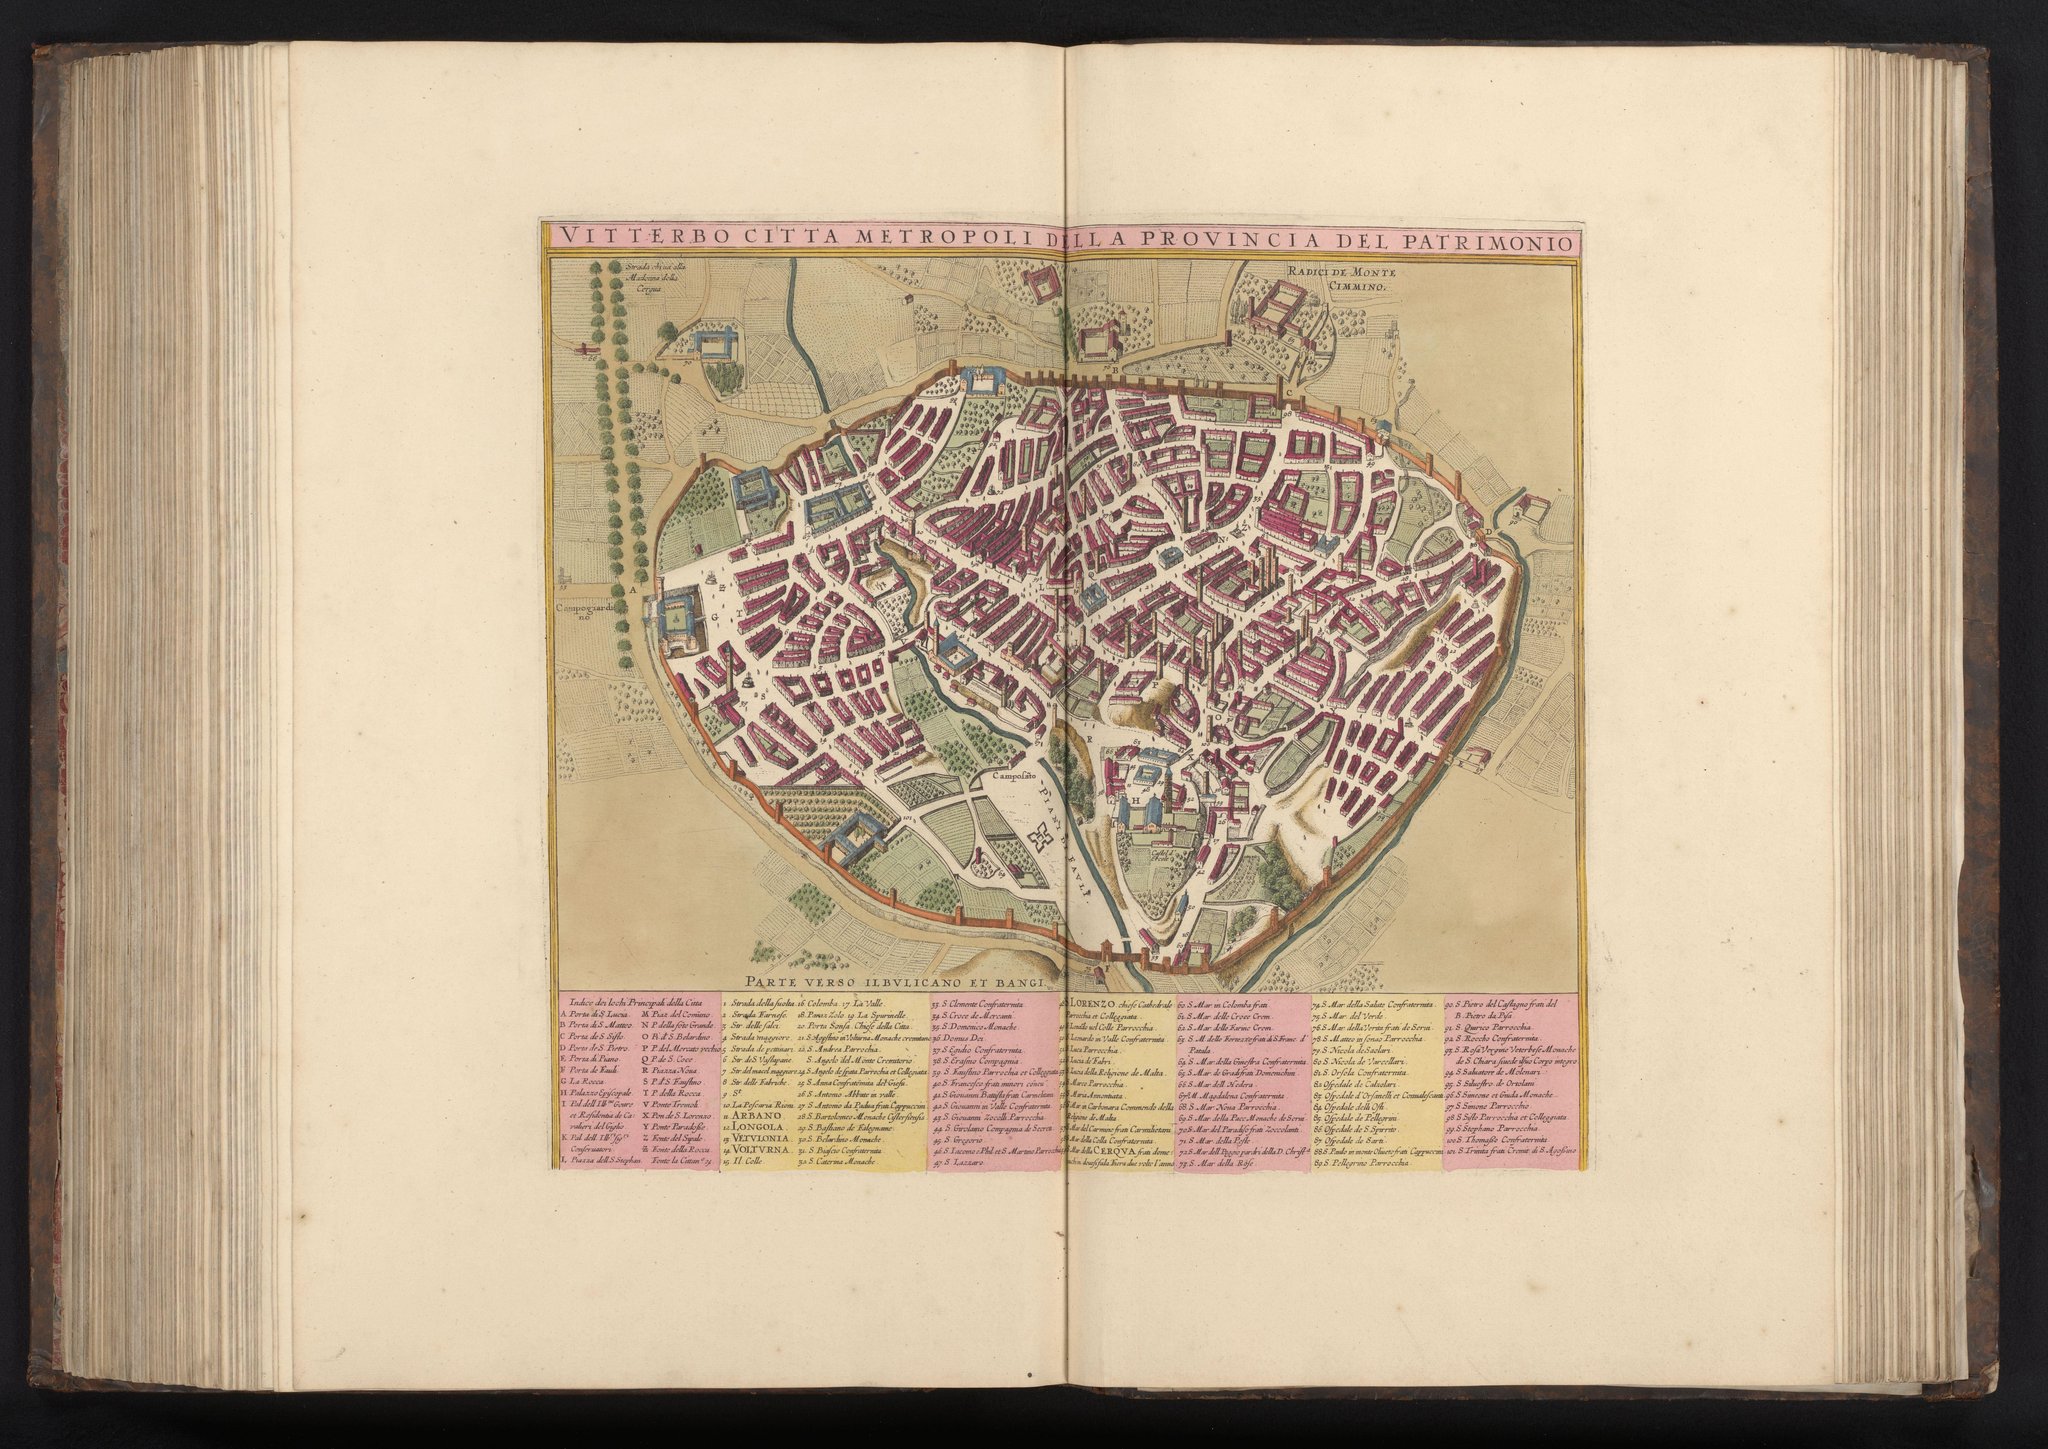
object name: album leaf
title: Vitterbo citta metropoli della provincia del patrimonio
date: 1617-1677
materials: paper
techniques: colour, etching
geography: the hague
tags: bird's eye view ~ architectural design or model, maps of cities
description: Gezicht op Viterbo in vogelvluchtperspectief. Boven de titel in het Italiaans. Onder een verklarende lijst met letters en nummers. Prent maakt deel uit van een album.